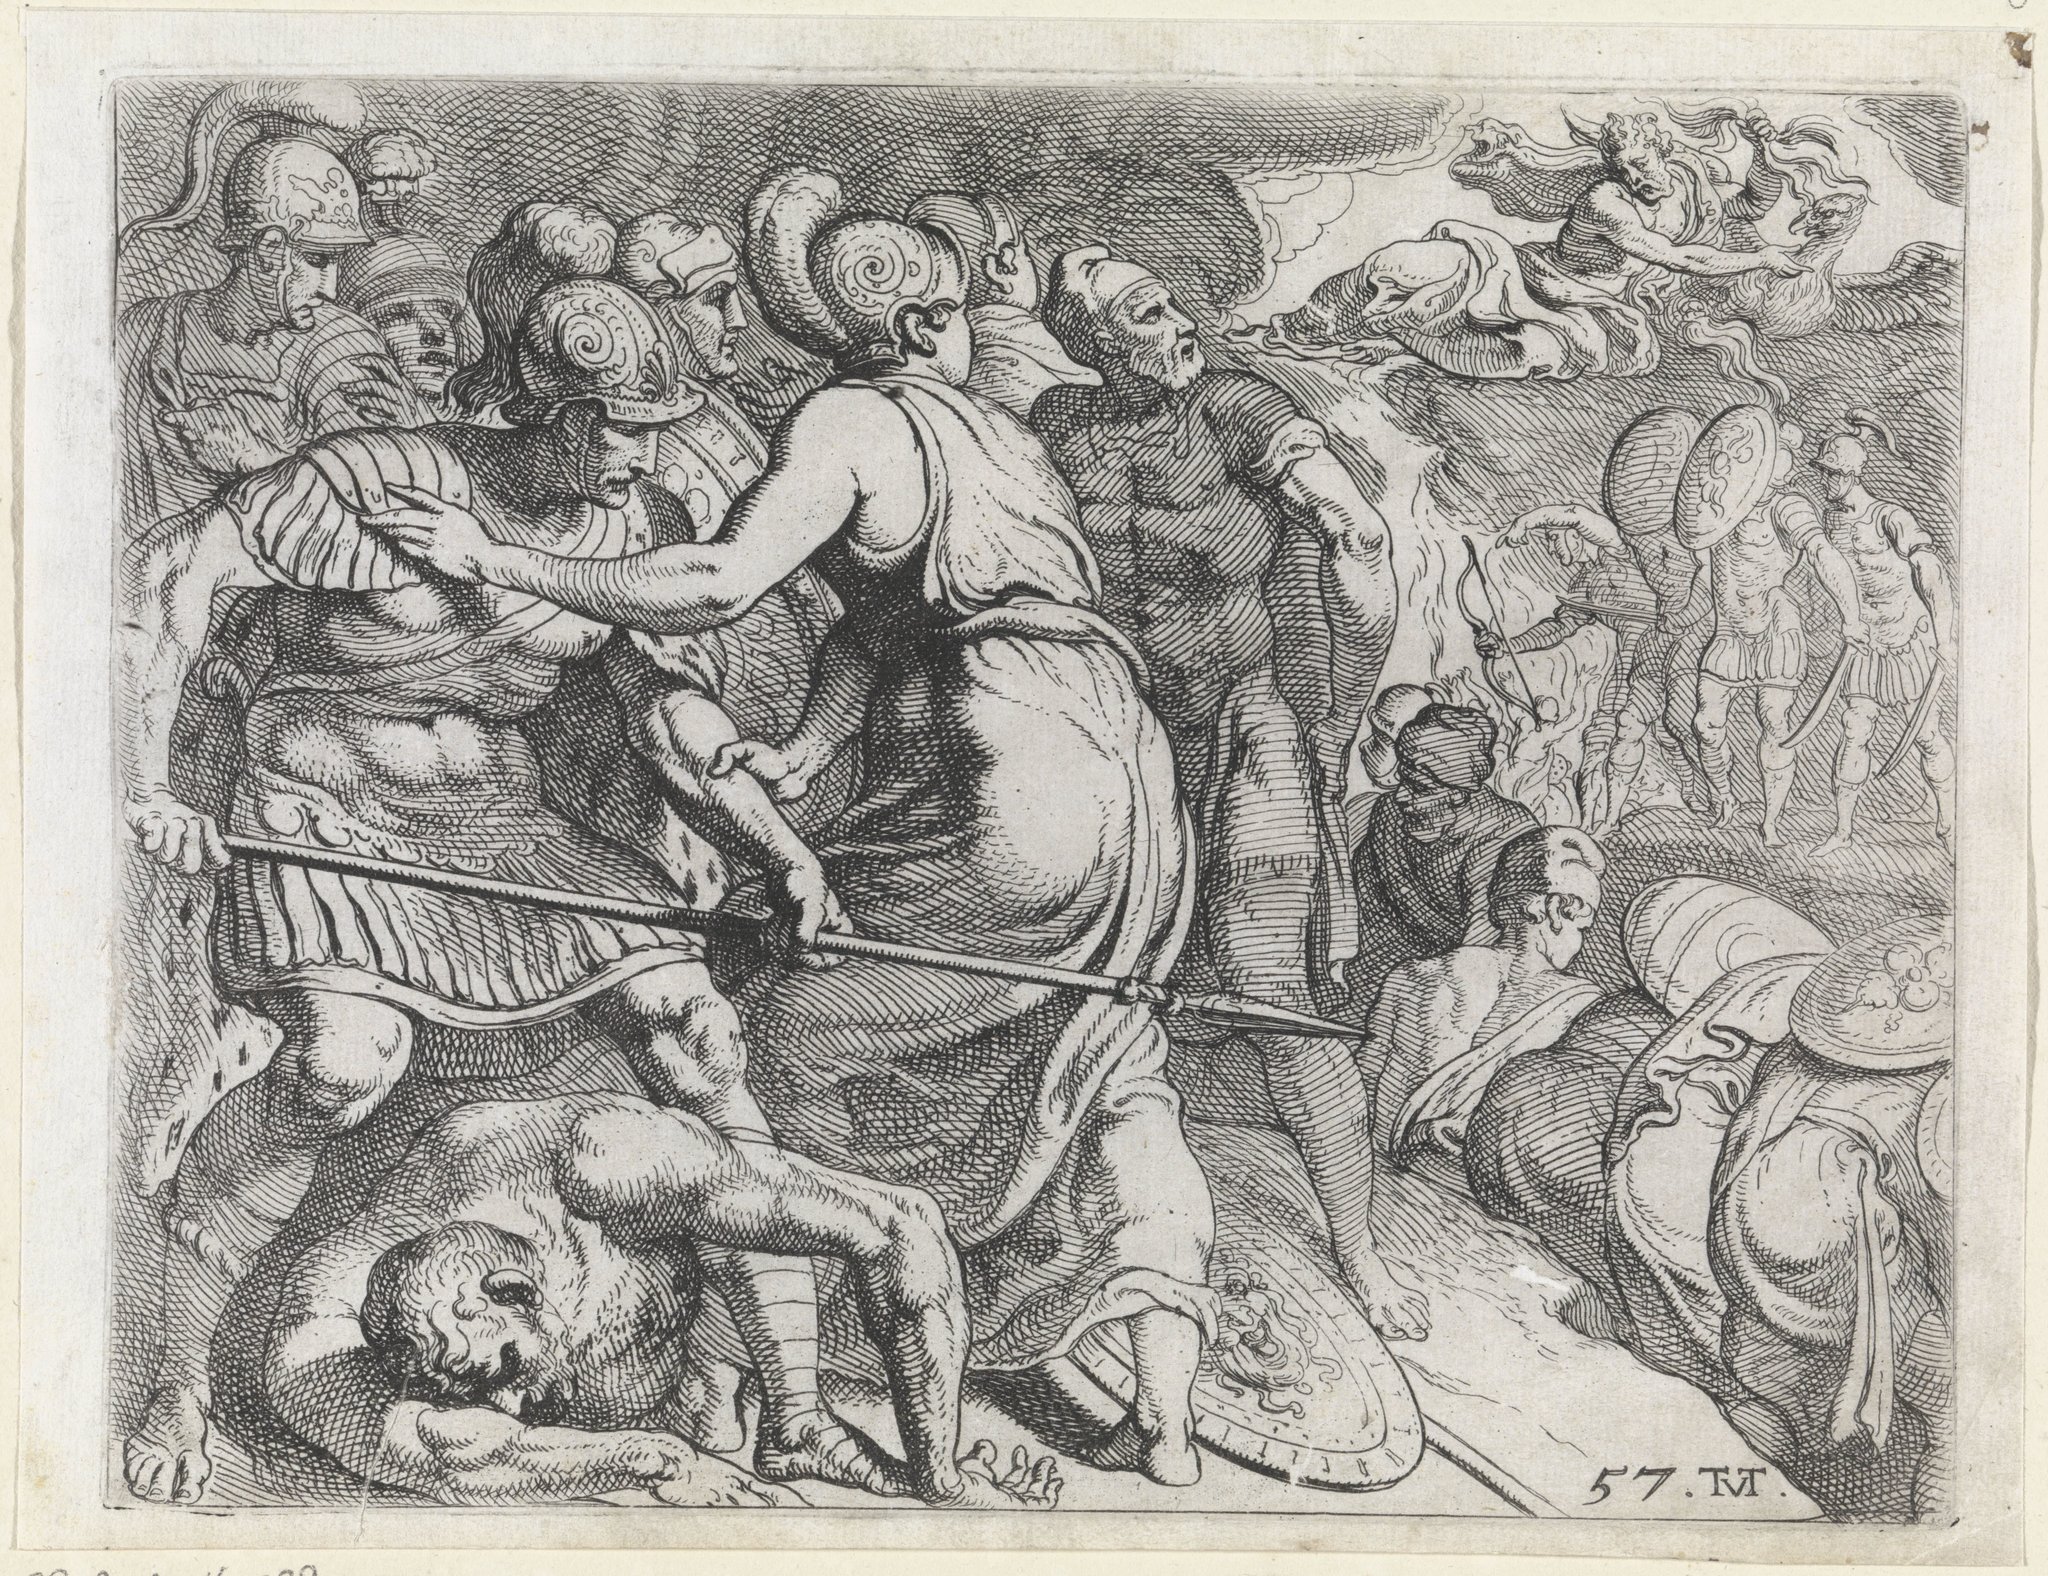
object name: print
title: Jupiter en Minerva stoppen de strijd tussen Odysseus en de Ithacanen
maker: theodoor van thulden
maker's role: draughtsman, painter, print maker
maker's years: 1606-1669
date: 1632-1633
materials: paper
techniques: engraving, etching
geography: paris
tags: minerva intervenes; reconciliation of ulysses and the ithacan rebels, (story of) jupiter (zeus), attributes of jupiter: thunderbolt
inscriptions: collector's mark: Lugt 2228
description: Jupiter stopt de strijd tussen Odysseus en de Ithacanen. Odysseus wordt tegengehouden door Minerva. Aan de voeten van hem ligt een dode man.